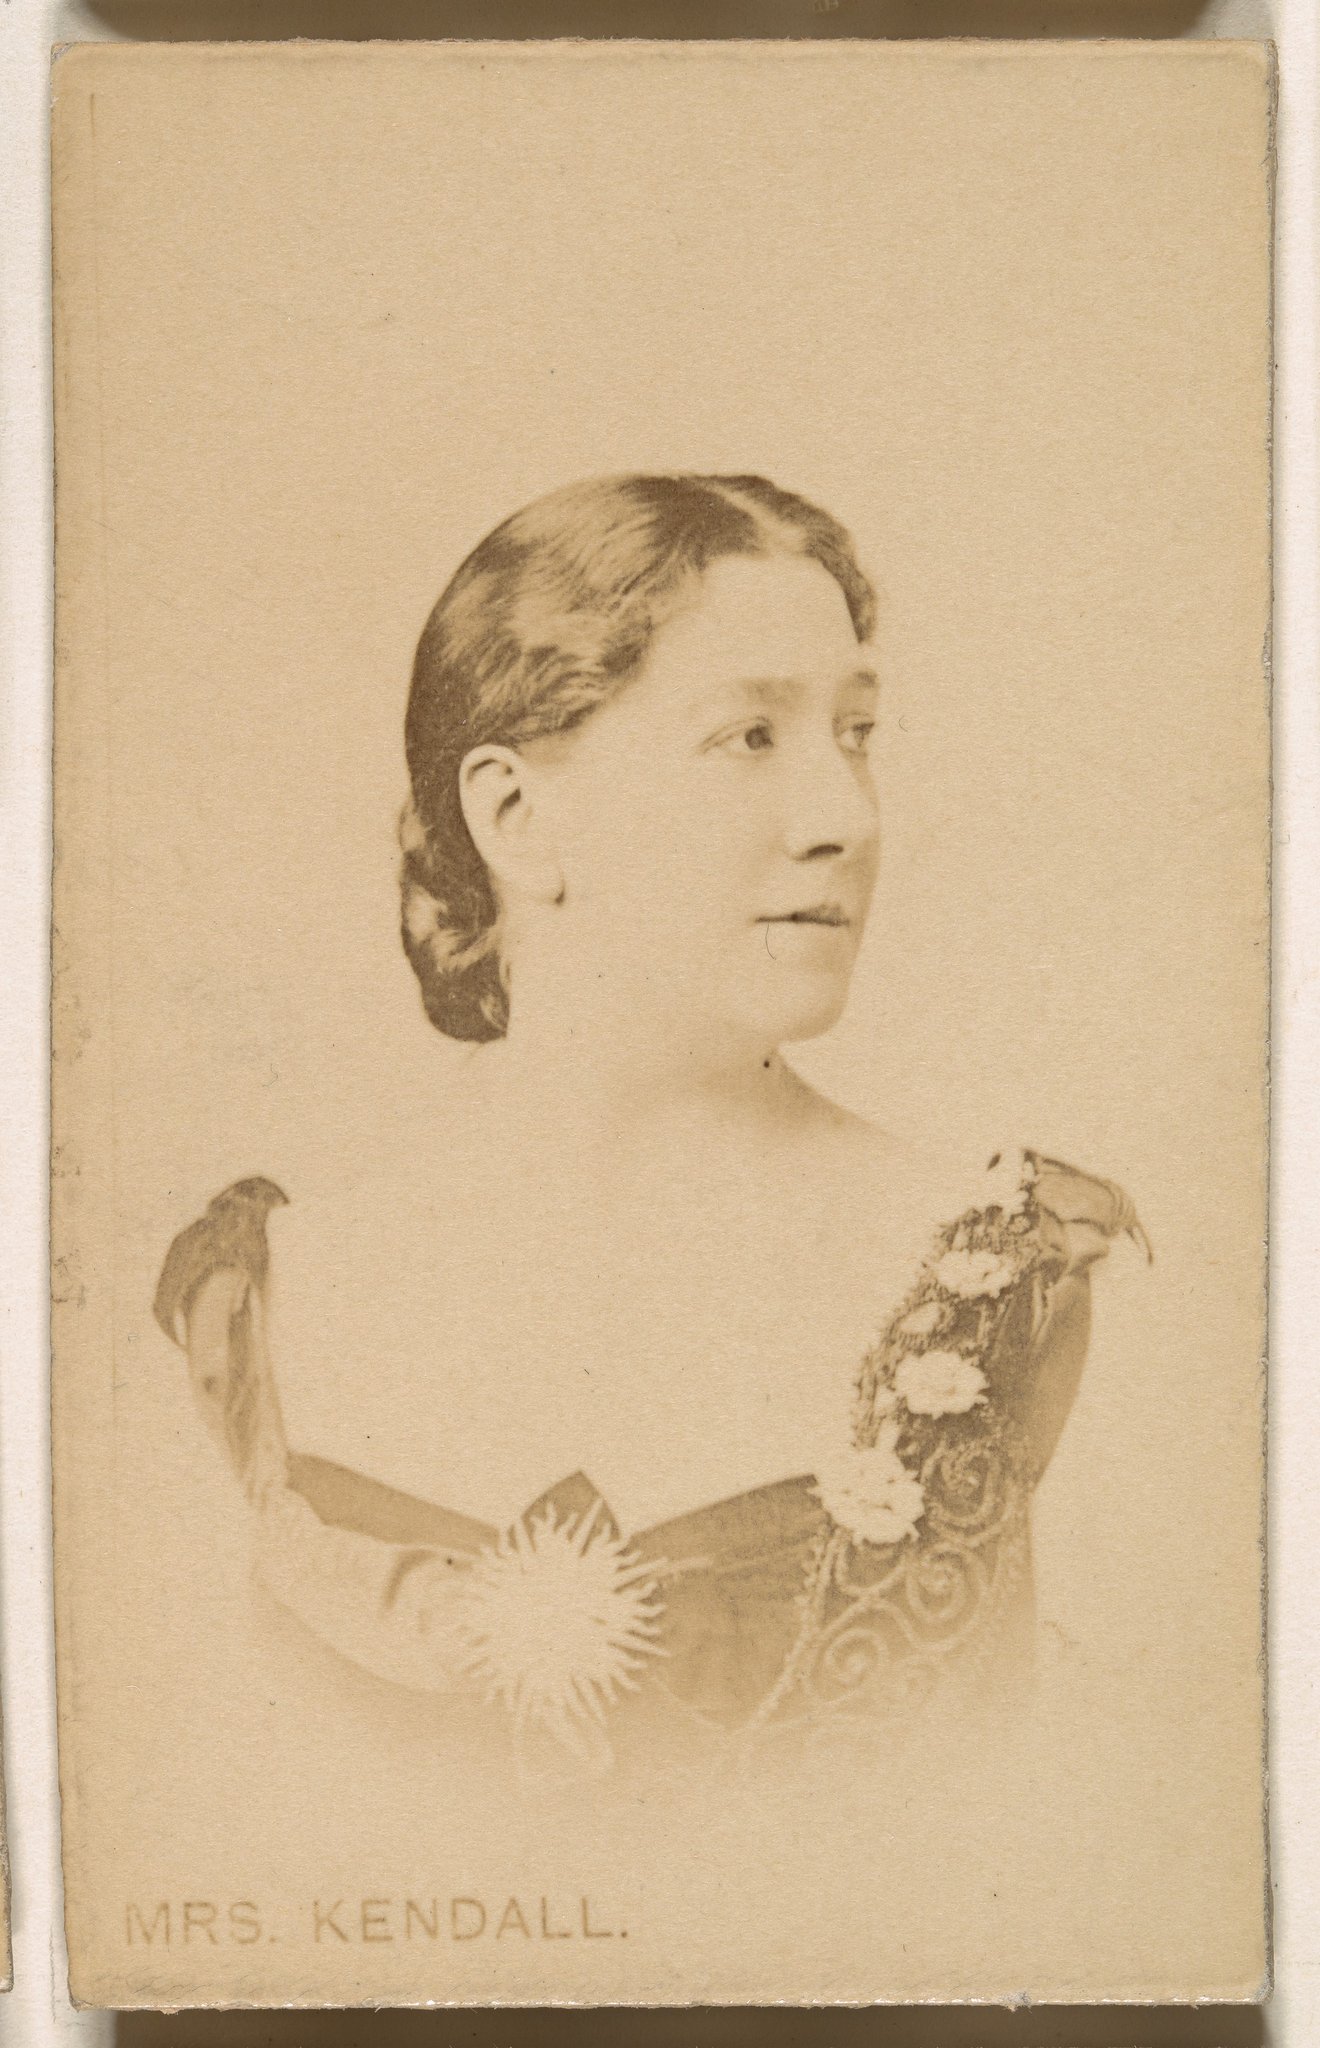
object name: photograph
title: Mrs. Kendall, from the Actresses series (N246), Type 1, issued by Kinney Brothers to promote Sporting Extra Cigarettes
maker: kinney brothers tobacco company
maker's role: publisher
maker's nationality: american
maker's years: 1869-2011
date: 1890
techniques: albumen silver print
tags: portraits,women,actresses